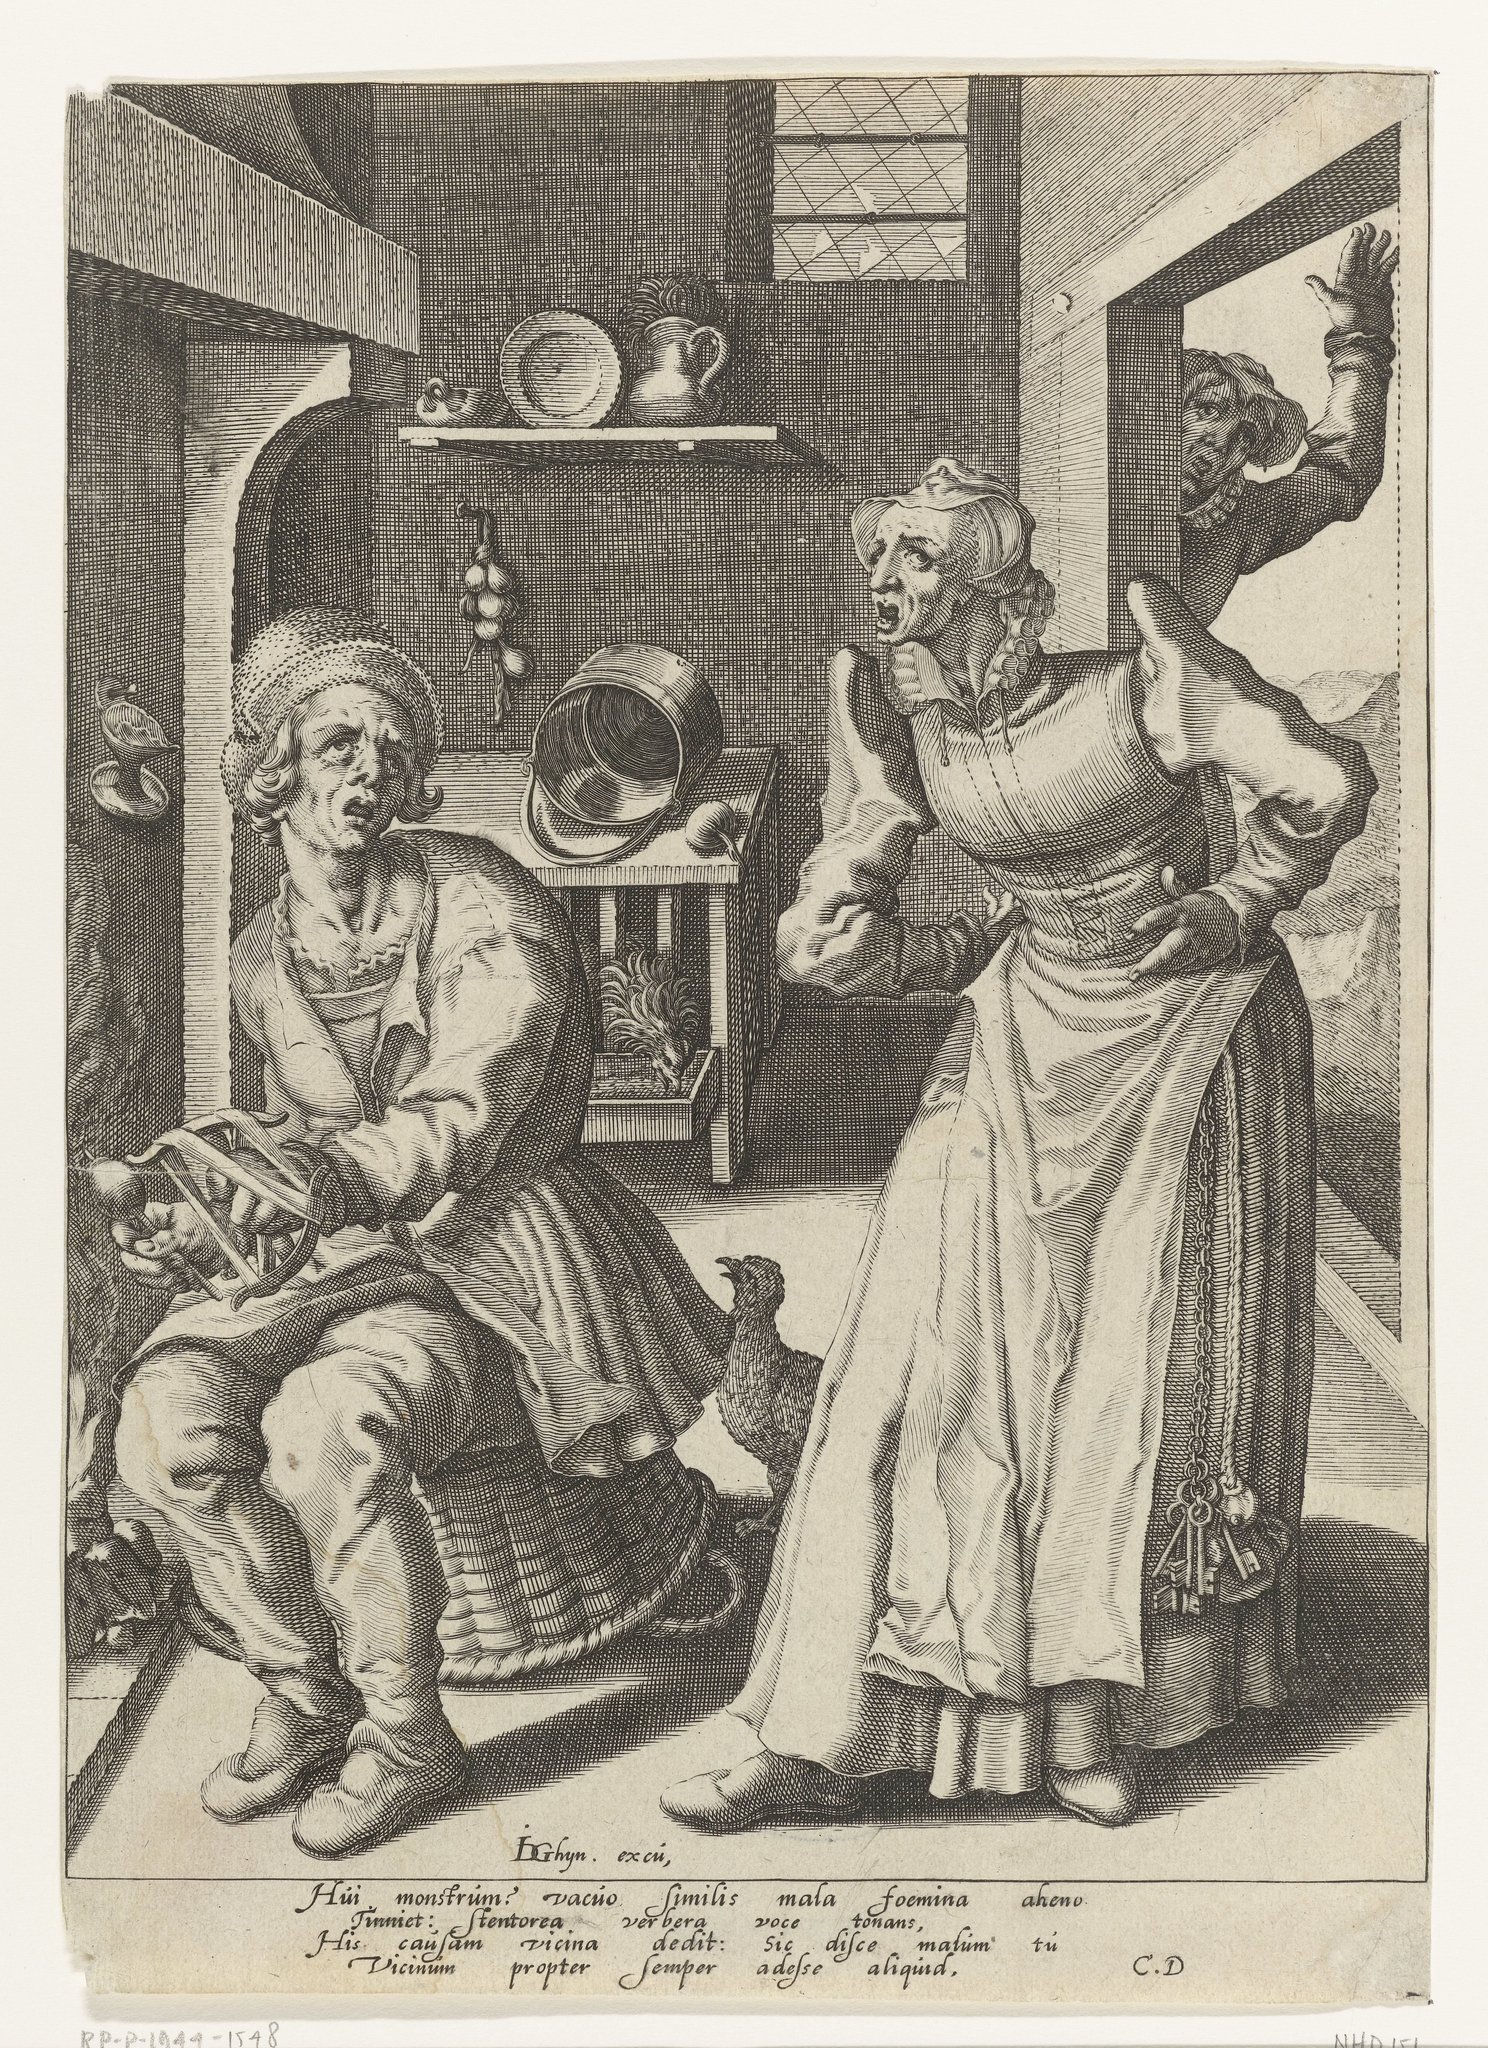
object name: print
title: Een kijvende vrouw en een spinnende man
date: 1593-1597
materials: paper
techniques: engraving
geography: netherlands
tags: man and wife quarrelling, 'marriage à la mode', fighting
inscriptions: collector's mark: Lugt 2228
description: Een vrouw staat in een keuken met de handen in de zij te schreeuwen naar een man die bij een haardvuur met spinattributen in de weer is. Op de achtergrond bij de deuropening het bovenlijf van een tweede vrouw, die de arm opsteekt. Onder de voorstelling vier regels tekst in Latijn.